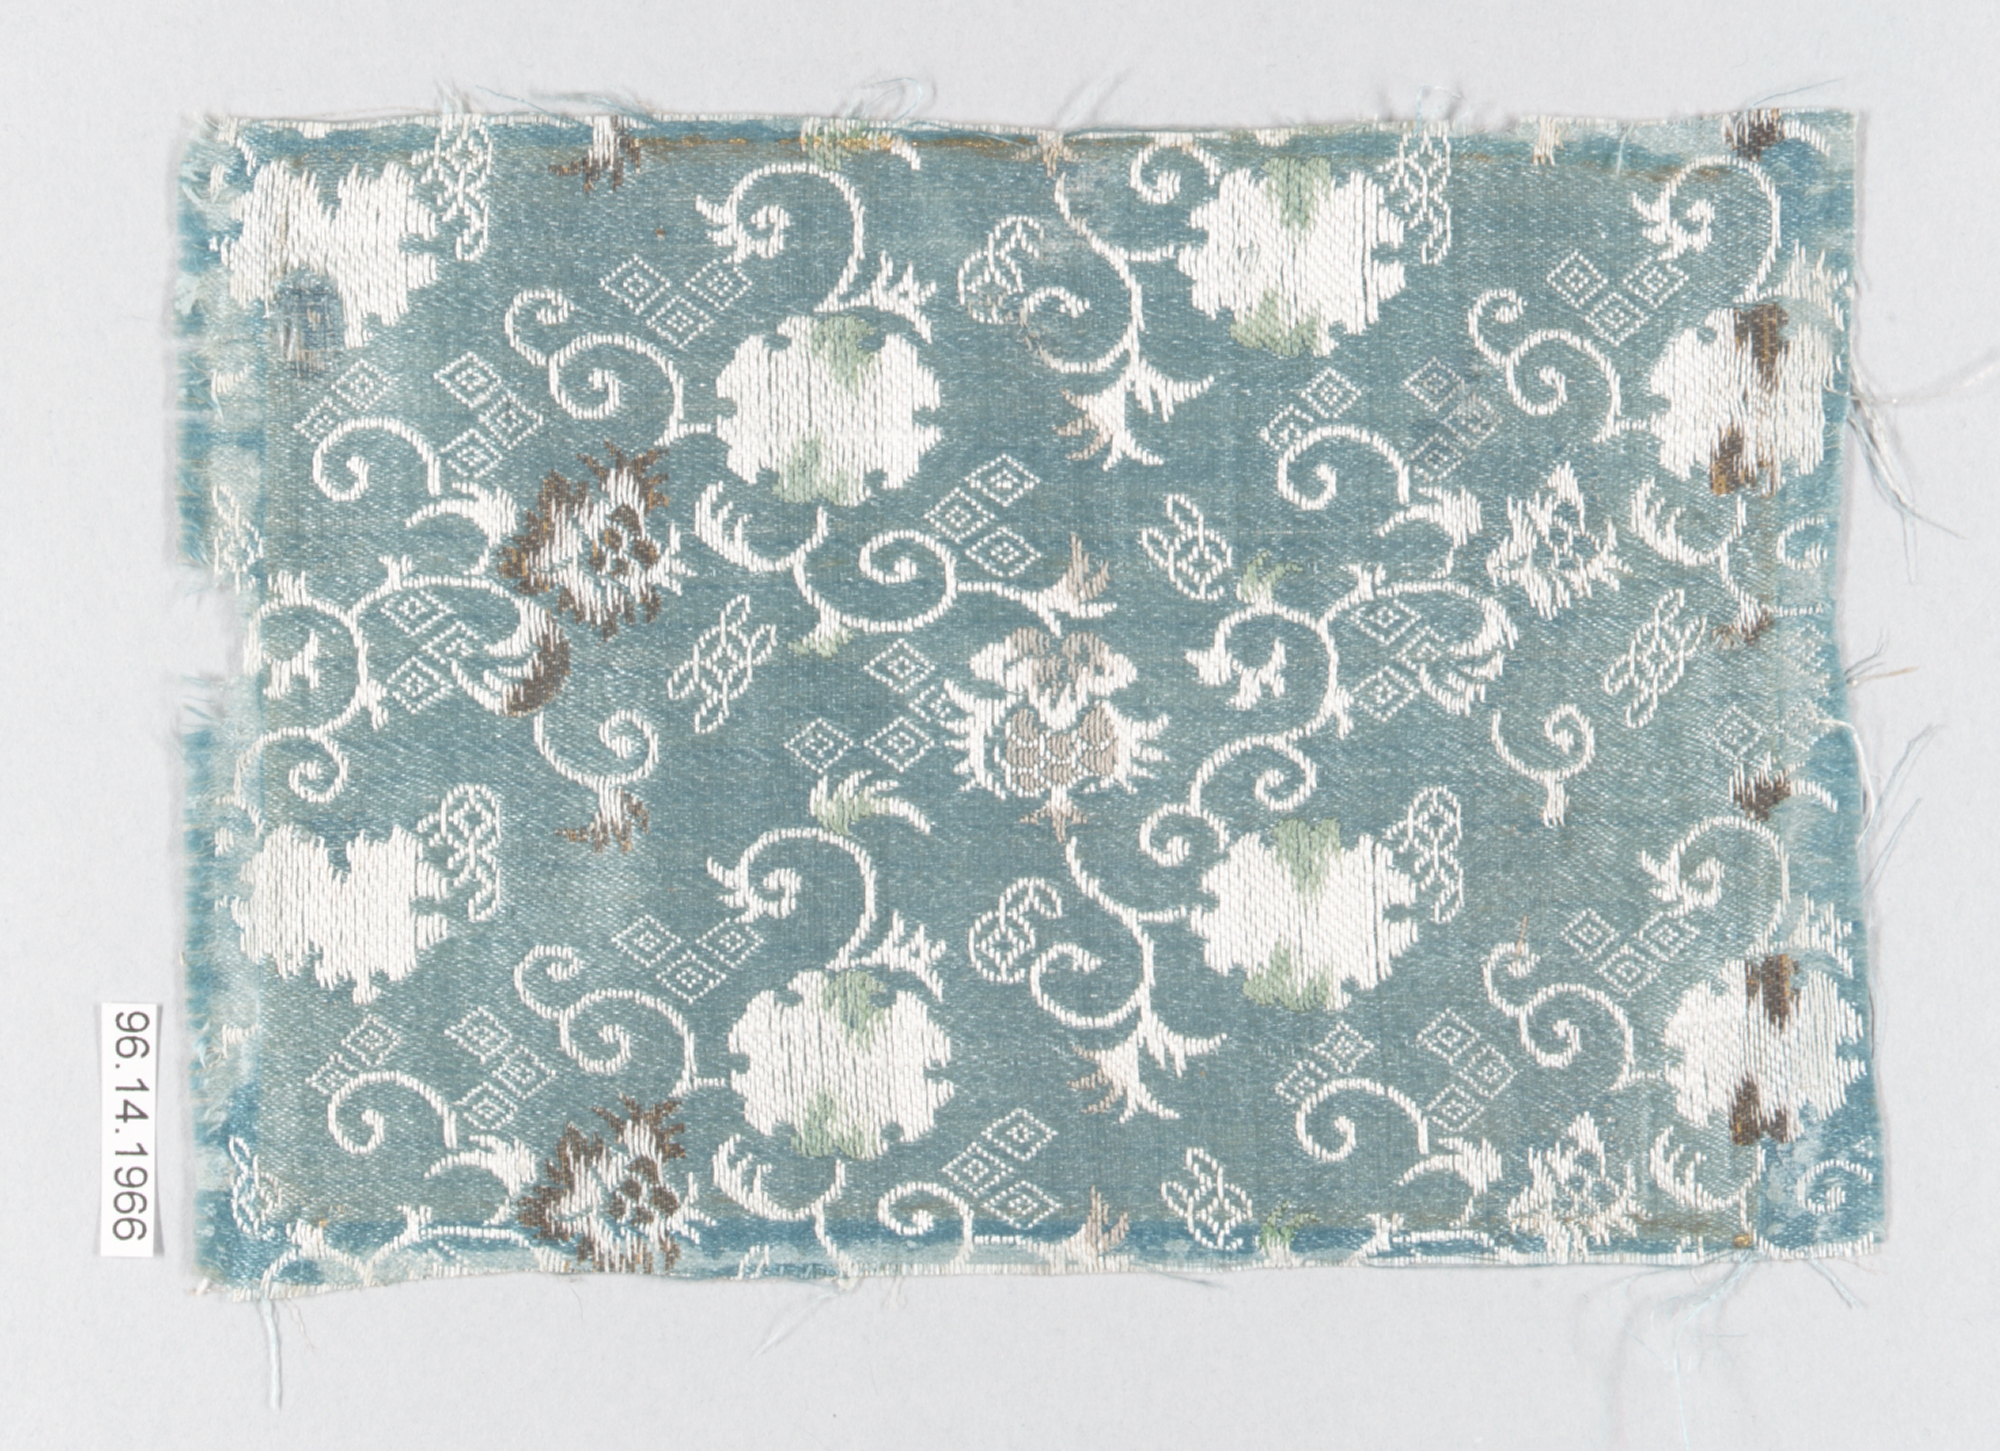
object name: piece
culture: japanese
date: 1701-1900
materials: silk